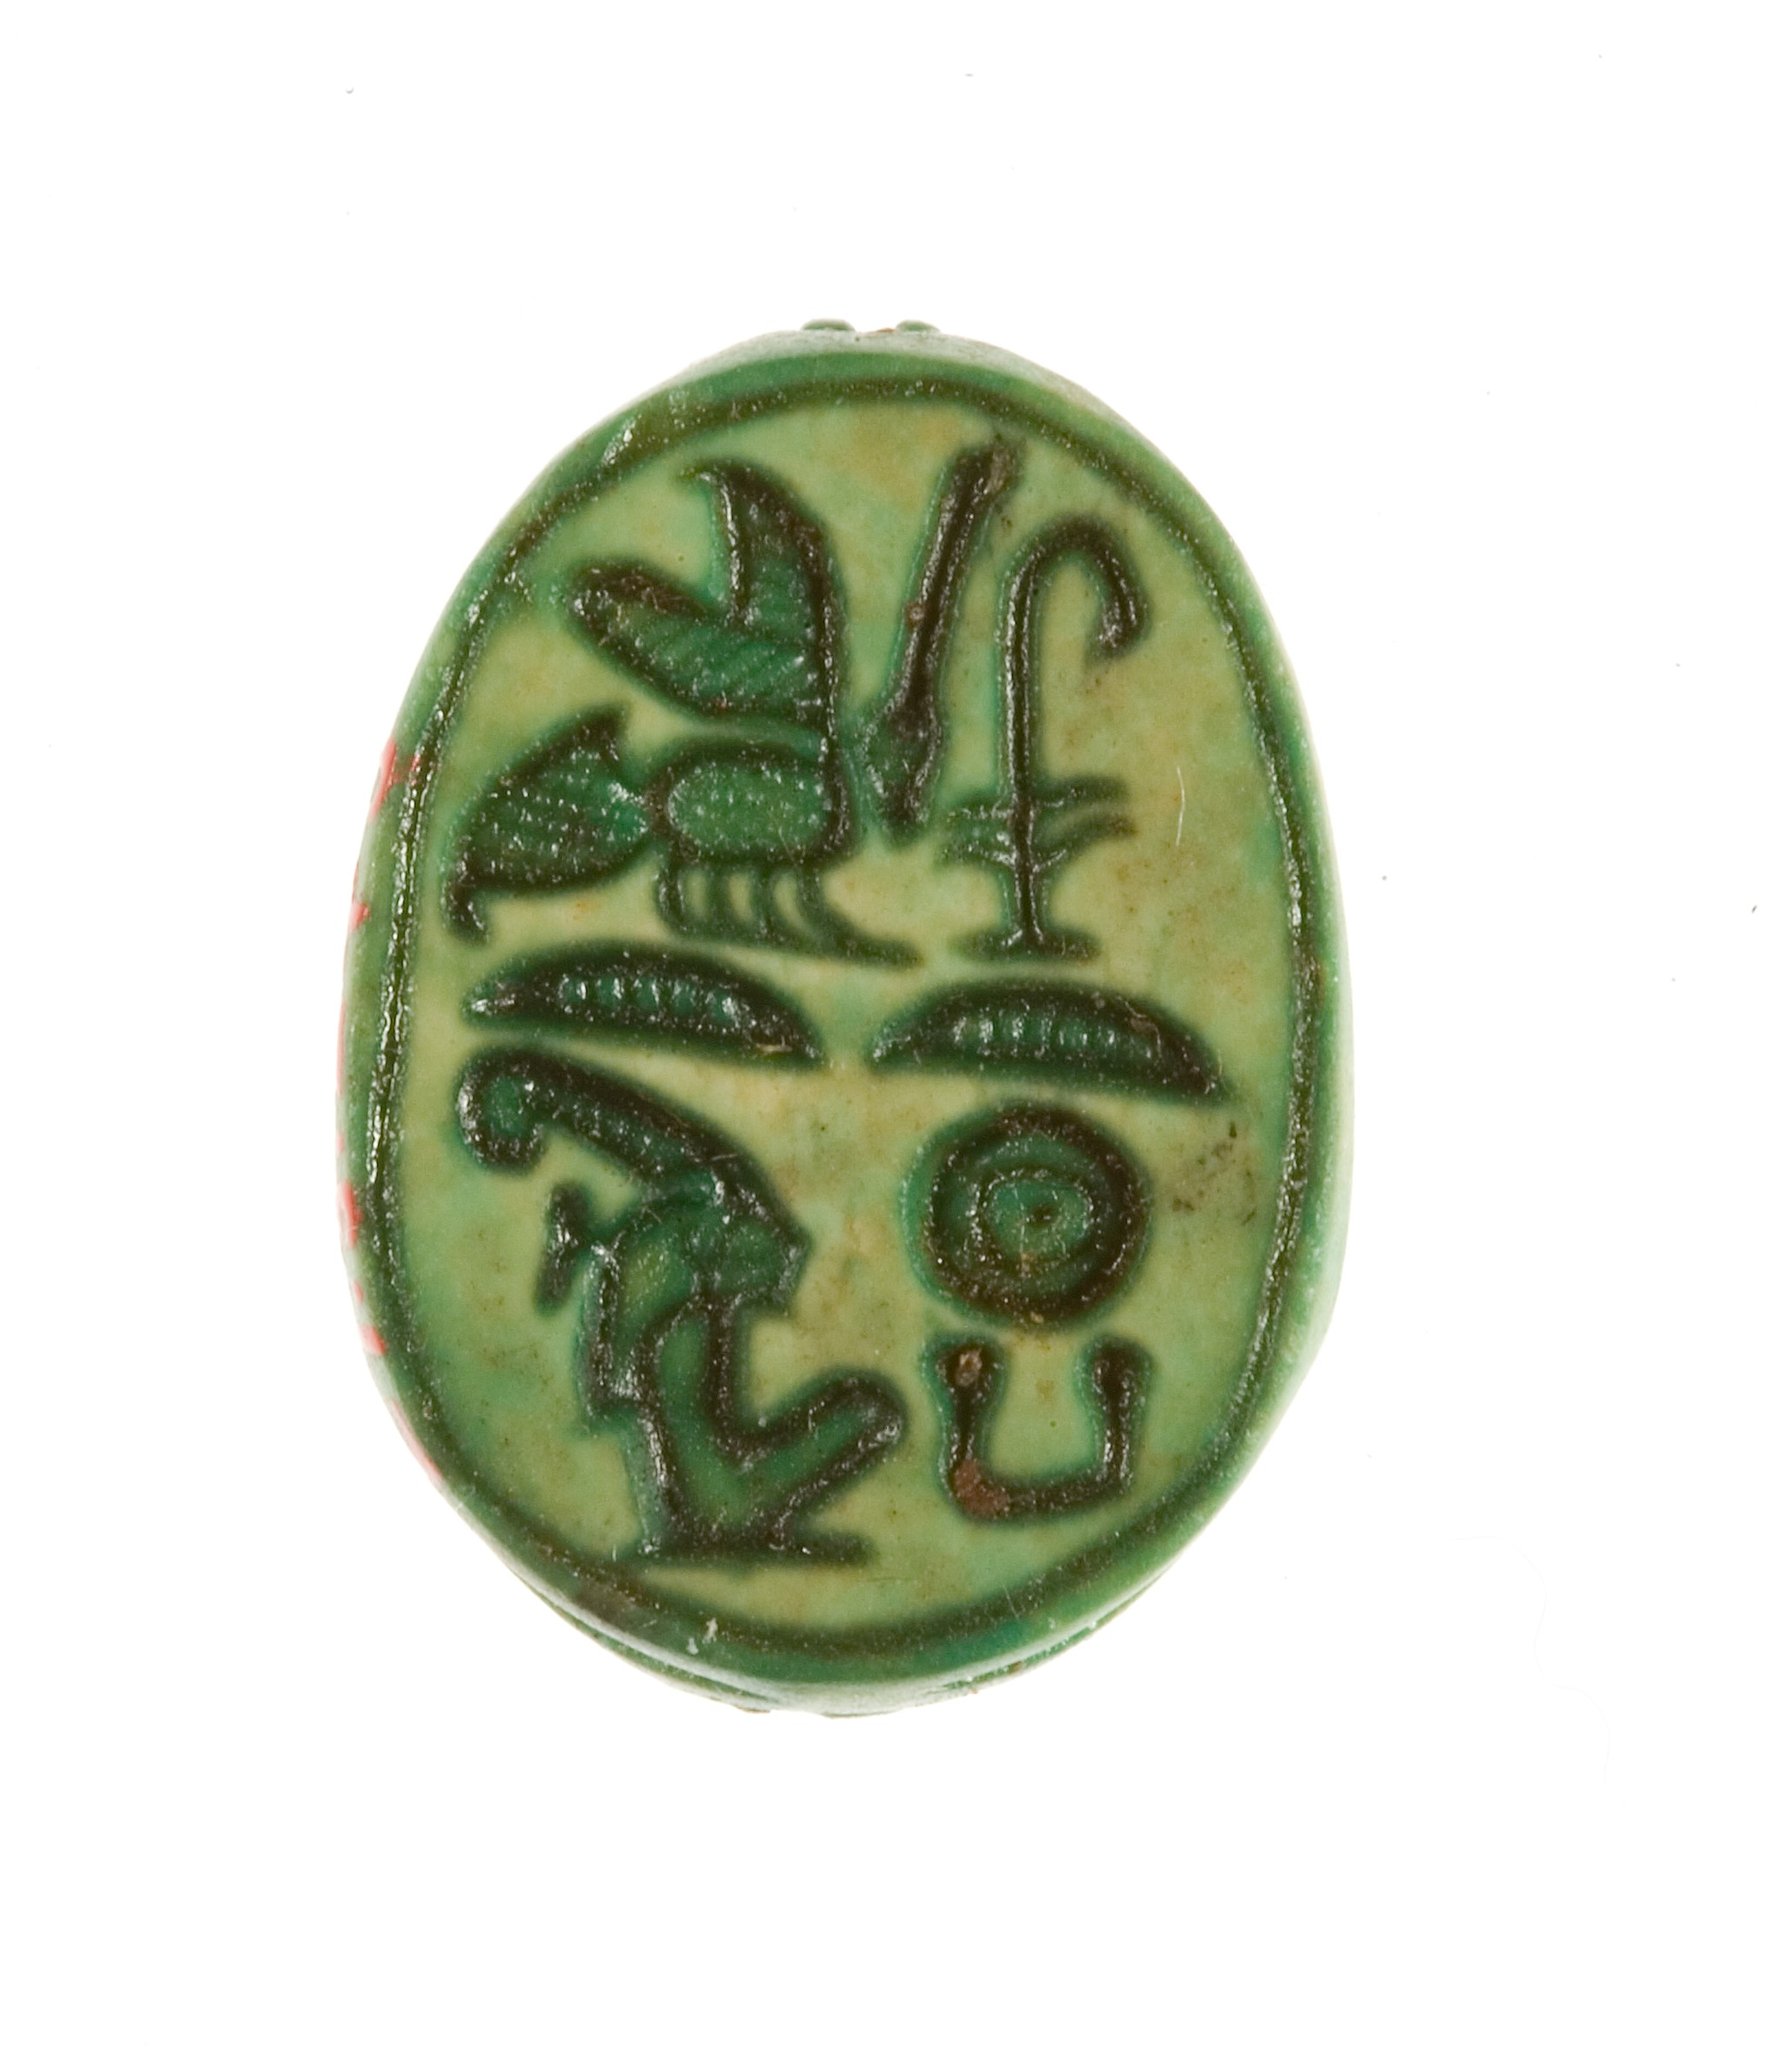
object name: scarab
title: Scarabs from Hatshepsut Foundation Deposits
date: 1479-1458 BCE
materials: stone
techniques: glazing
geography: egypt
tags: hieroglyphs,scarabs